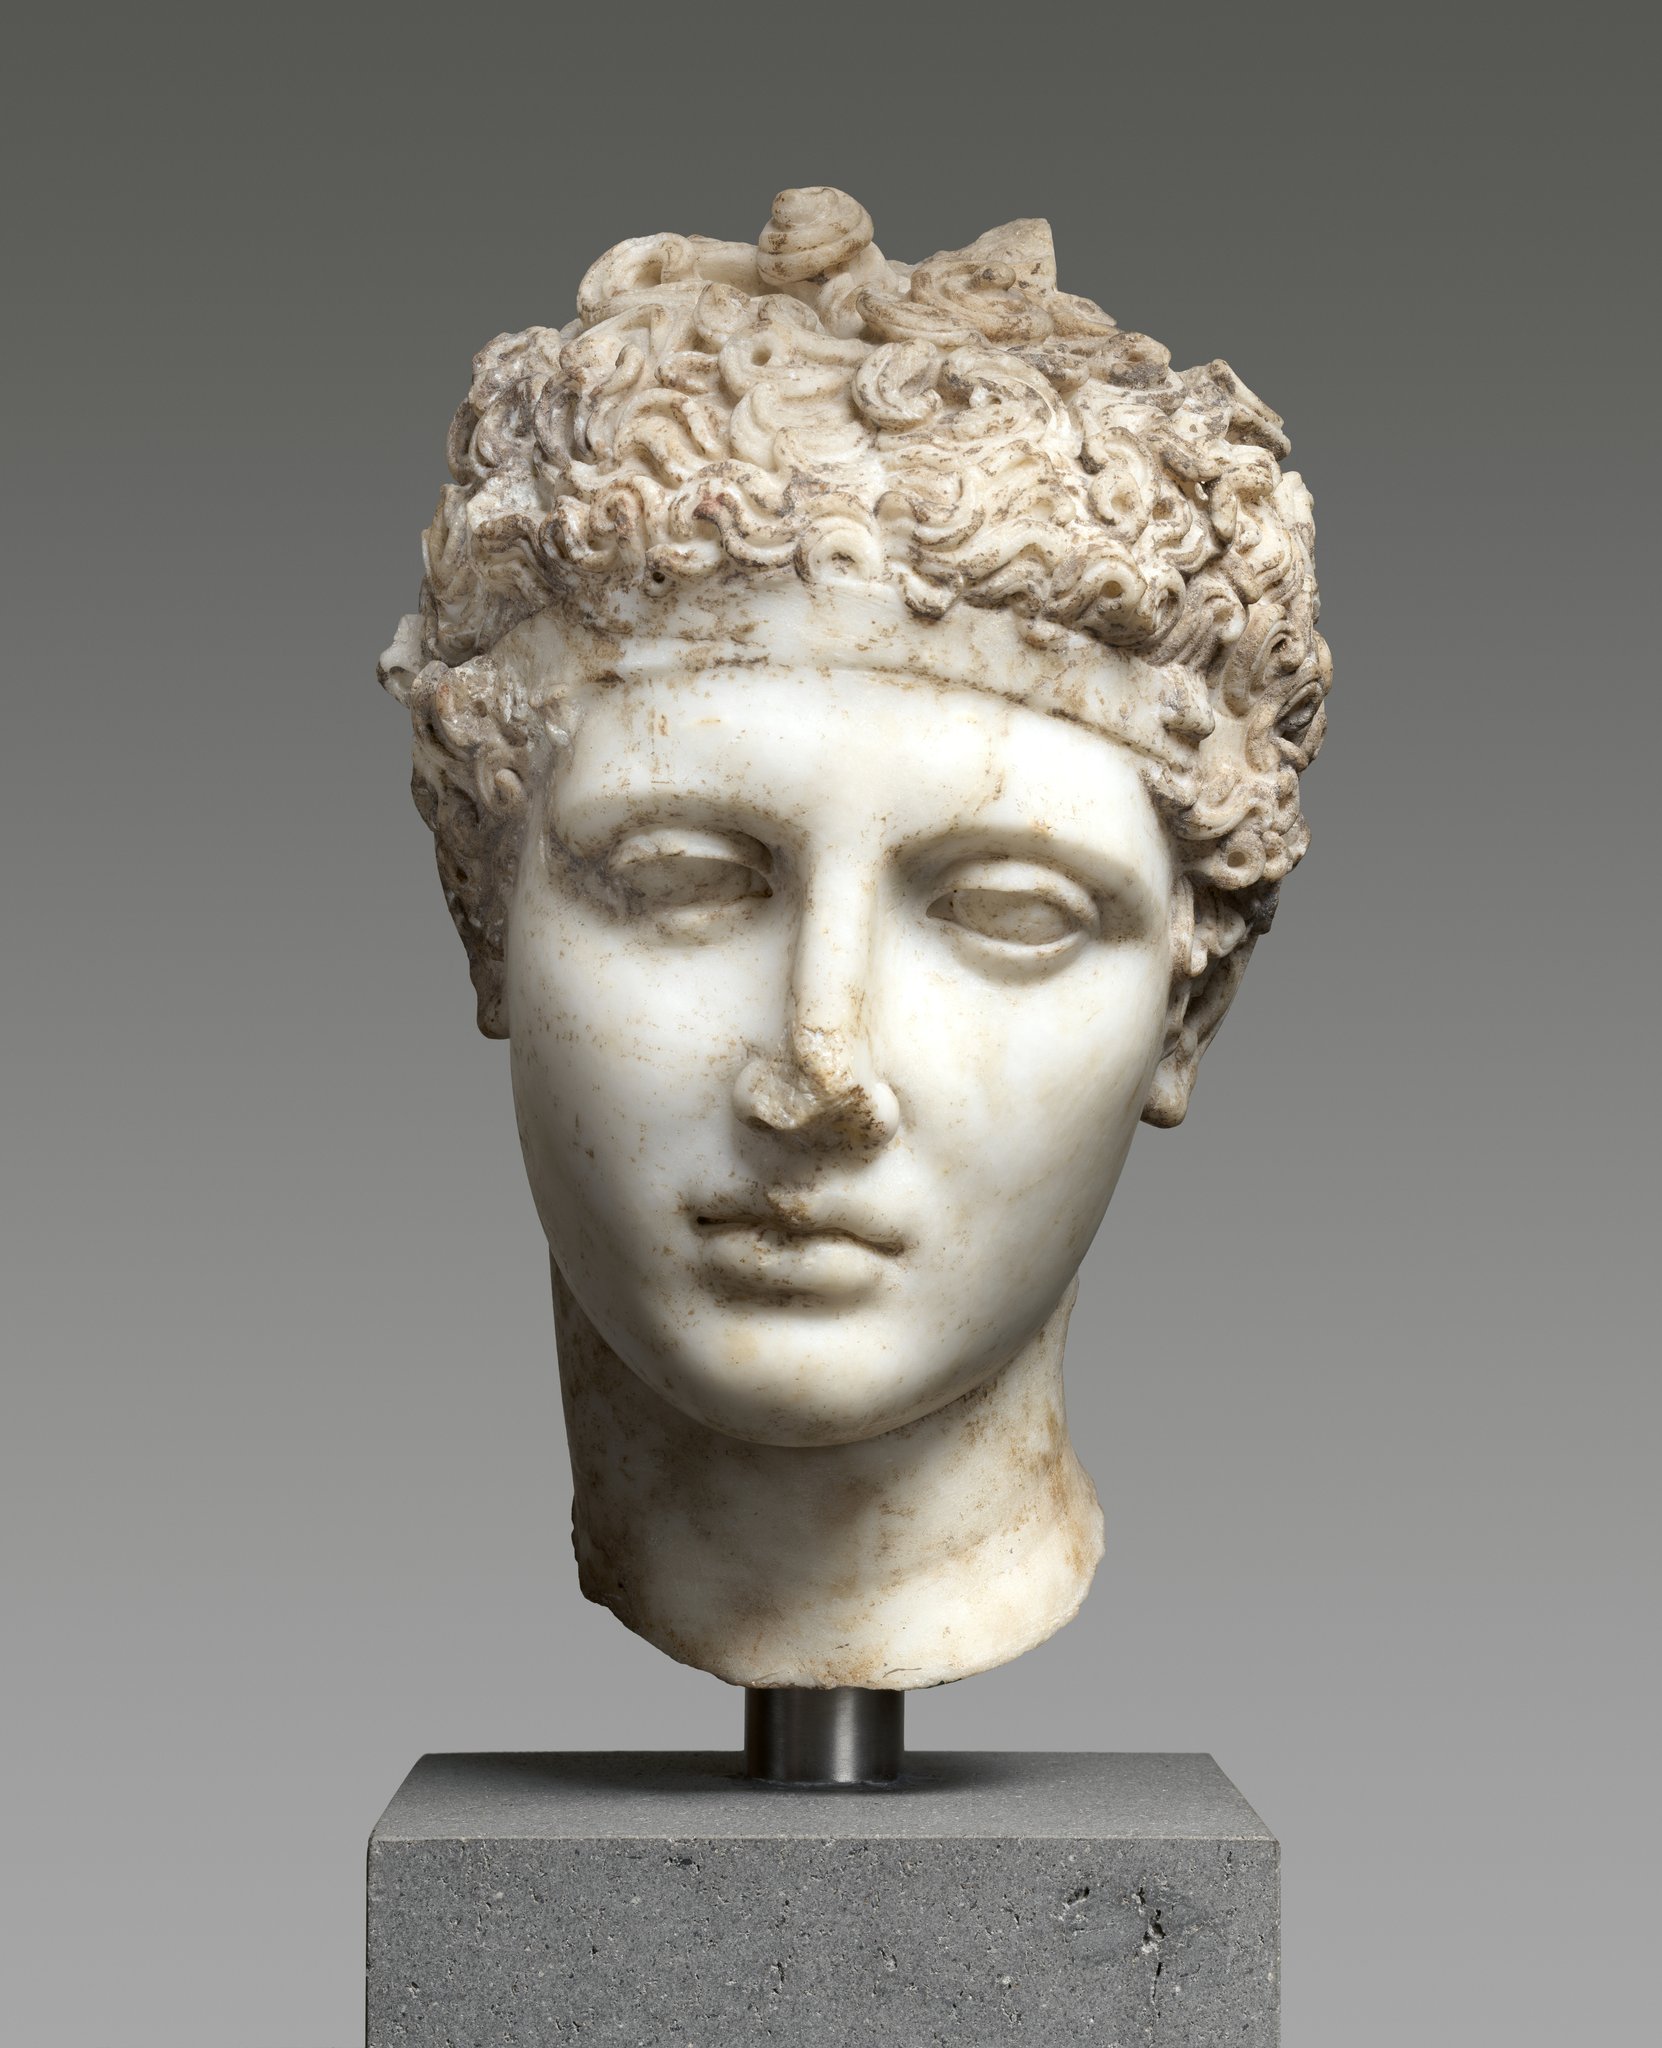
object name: head of an athlete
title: Marble head of an athlete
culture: roman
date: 138-192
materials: marble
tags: heads,men,athletes